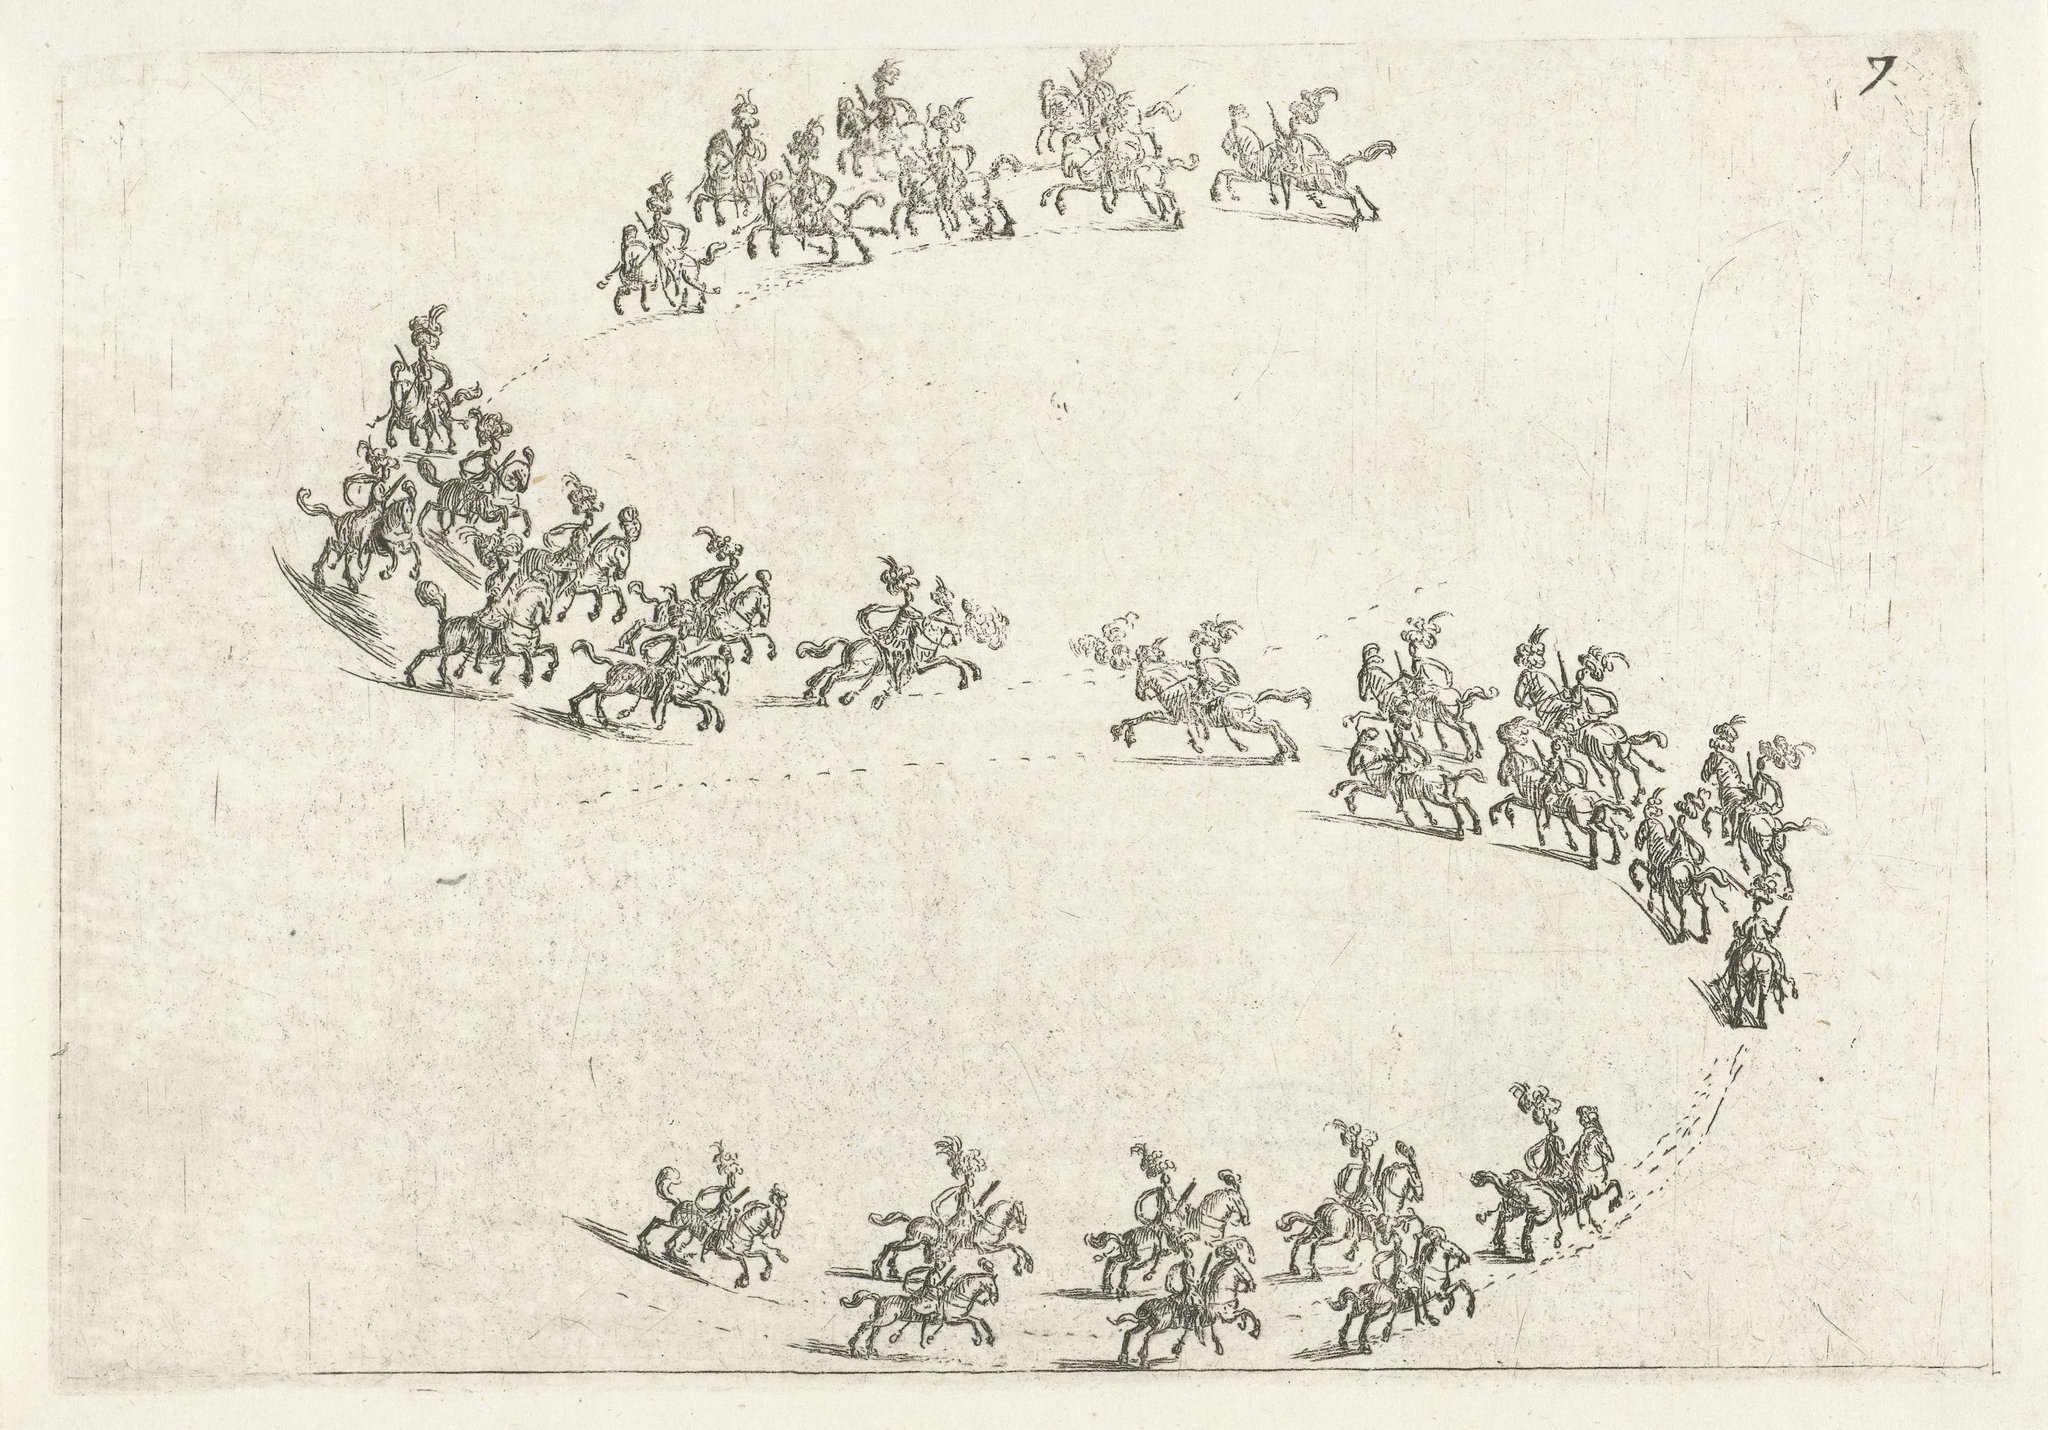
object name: print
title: Beweging van ruiters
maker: nikolaas van hoy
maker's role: draughtsman, painter, print maker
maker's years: 1631-1679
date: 1667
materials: paper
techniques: etching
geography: vienna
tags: horse in motion, military honours (+ cavalry, horsemen), carrousel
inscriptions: collector's mark: Lugt 2228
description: Ruiters in beweging. Zevende prent van een serie van prenten met ruiterformaties behorende bij het carrouselrijden, opgevoerd tijdens het huwelijk van Leopold I met Margaretha Theresia van Spanje.